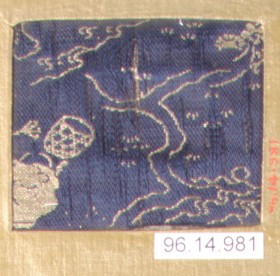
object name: piece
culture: japanese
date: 1701-1900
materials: silk